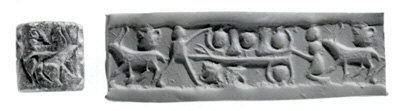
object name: cylinder seal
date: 3000-2001 BCE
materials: mineral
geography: syria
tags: animals